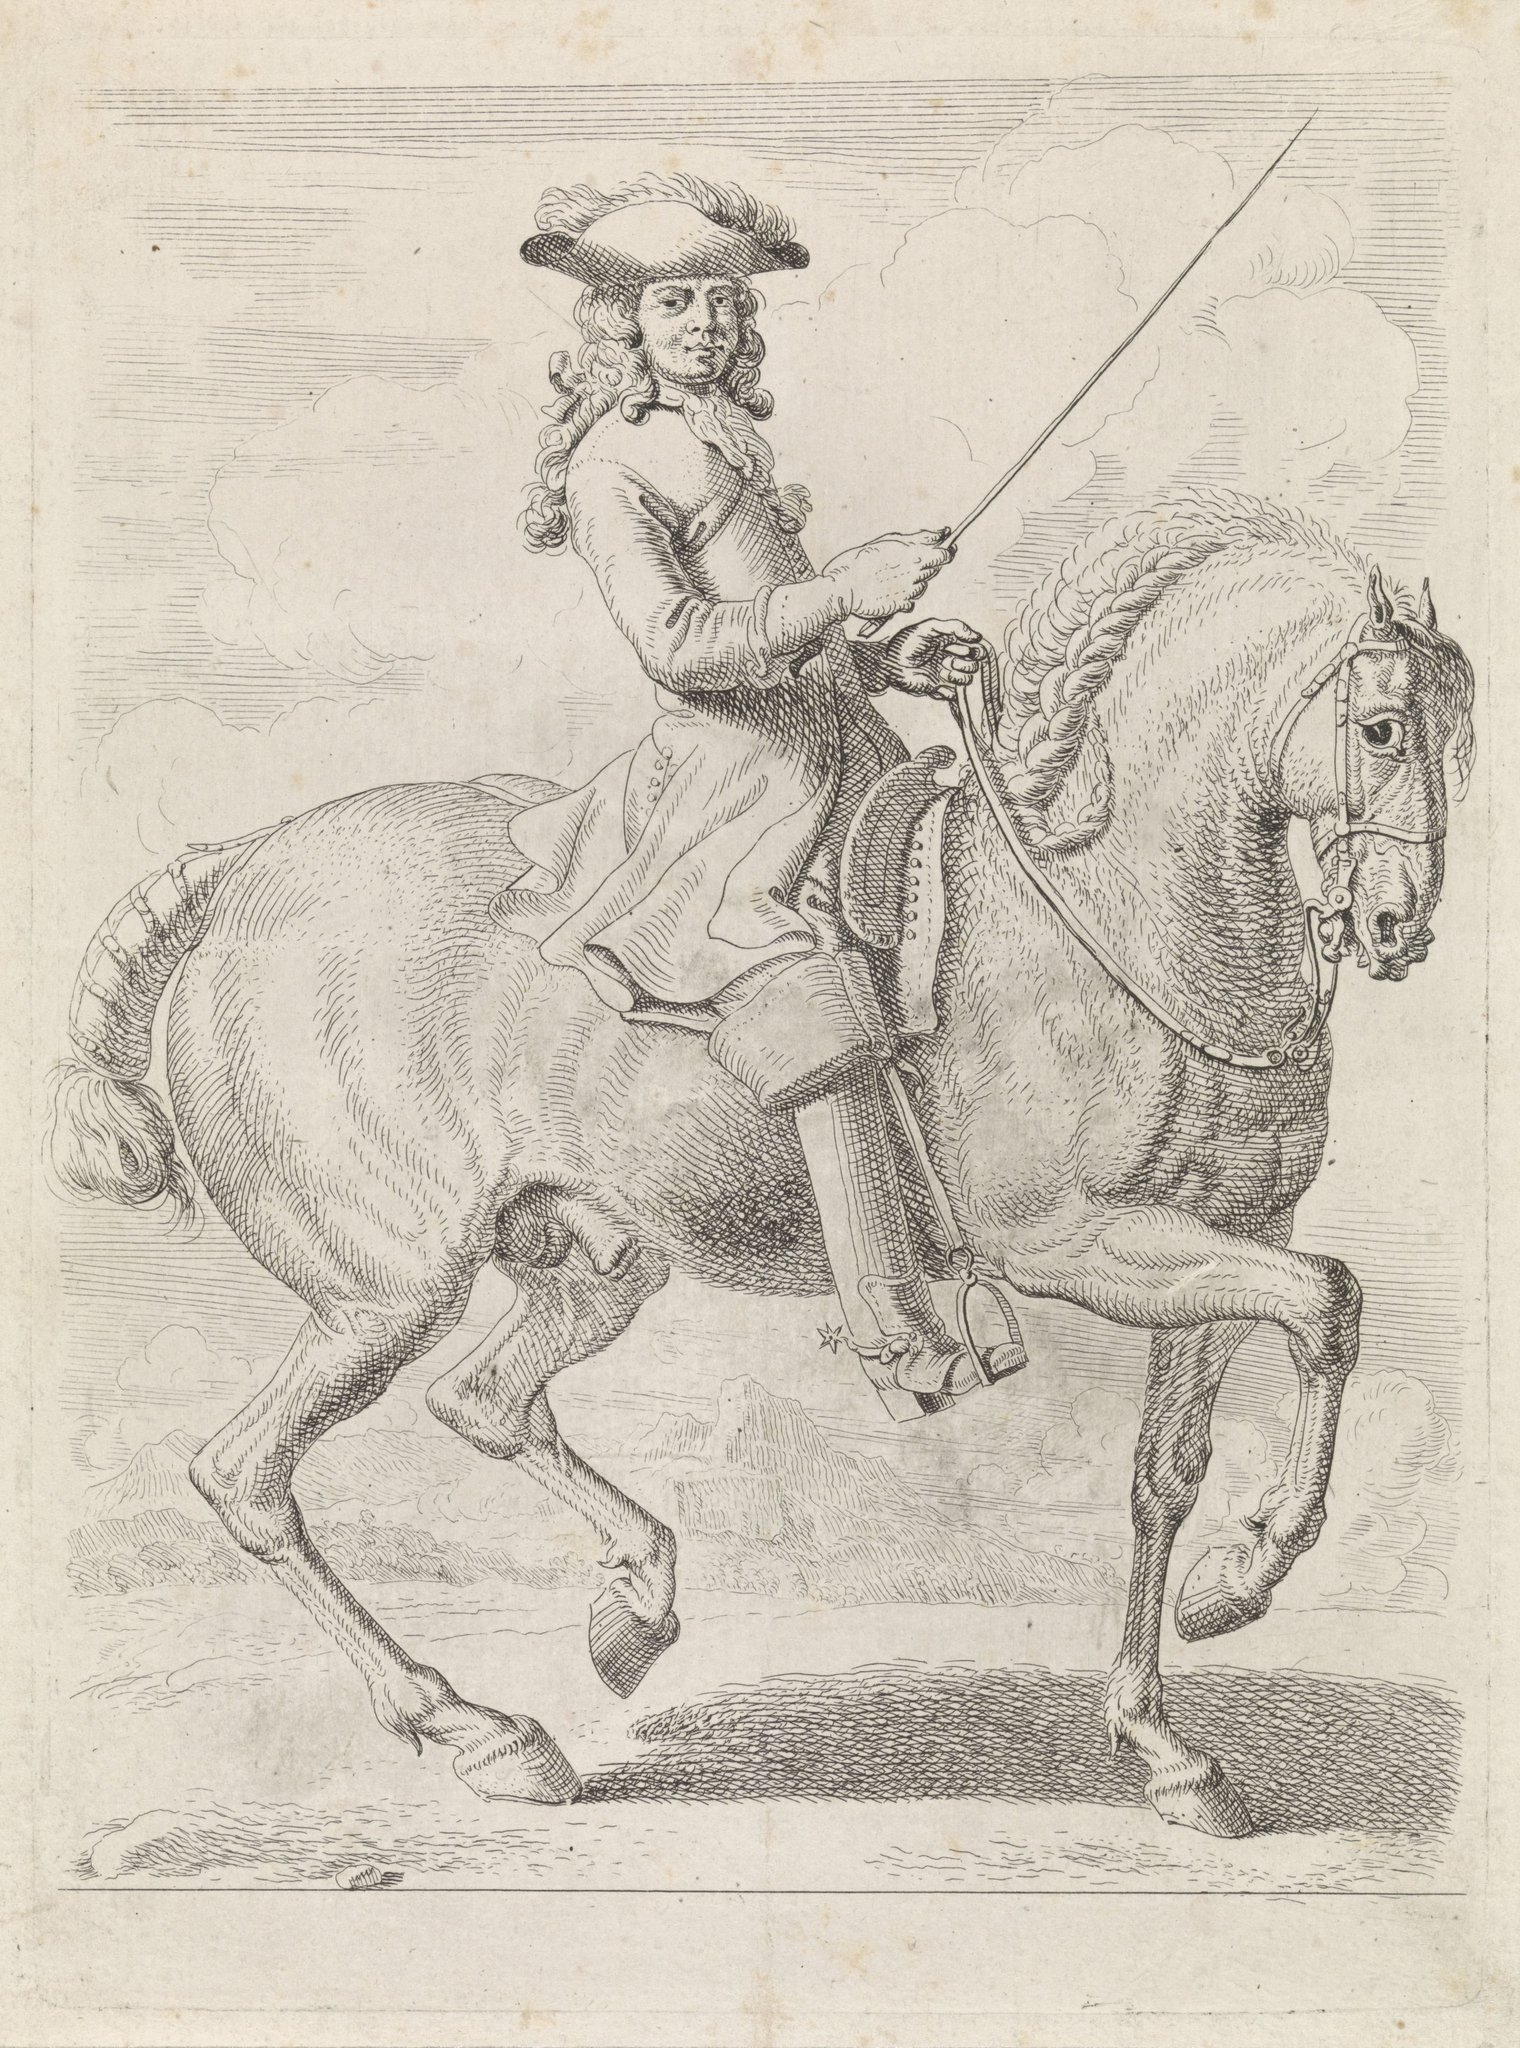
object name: print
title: Ruiter in rust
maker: dirk maas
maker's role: draughtsman, print maker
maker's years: 1659-1717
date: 1669-1717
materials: paper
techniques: etching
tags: riding a horse, ass, or mule; rider, horseman, training of horses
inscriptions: collector's mark: Lugt 2228, collector's mark: Lugt 138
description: Ruiter naar rechts. Prent van een serie van twee prenten met ruiters die hun paarden trainen.